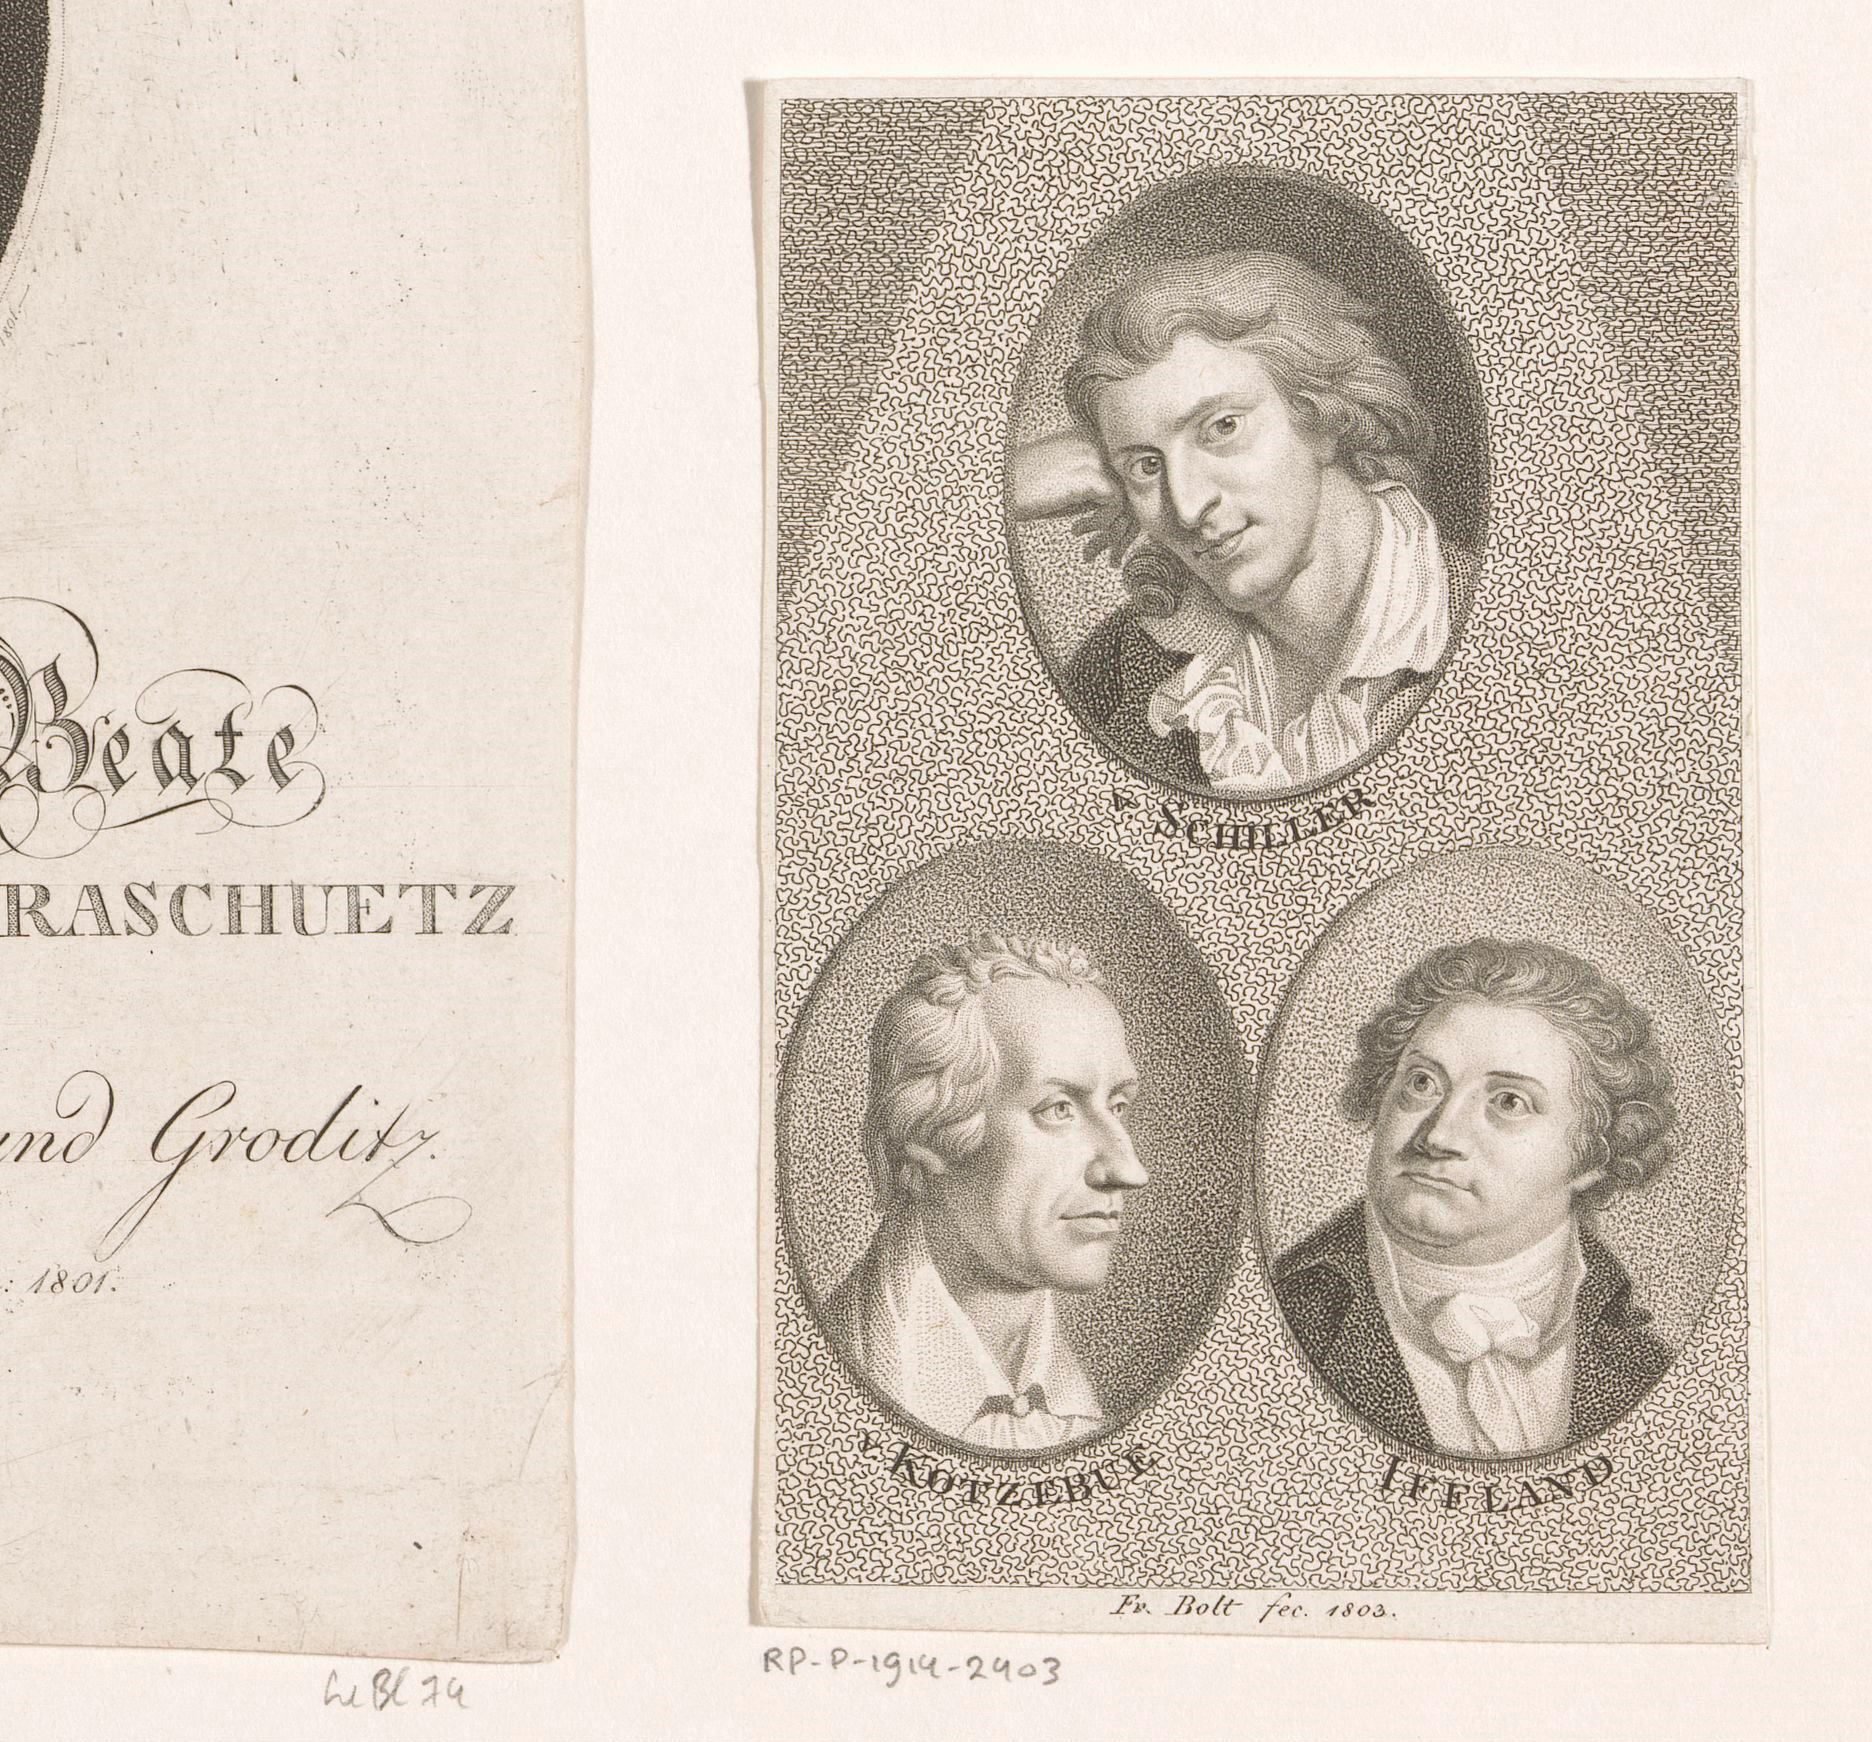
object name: print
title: Portretten van Friedrich von Schiller, August von Kotzebue en August Iffland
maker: johann friedrich bolt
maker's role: print maker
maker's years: 1769-1836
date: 1803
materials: paper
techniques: etching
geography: berlin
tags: friedrich von schiller, historical persons, writer, poet, author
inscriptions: collector's mark: Lugt 2228